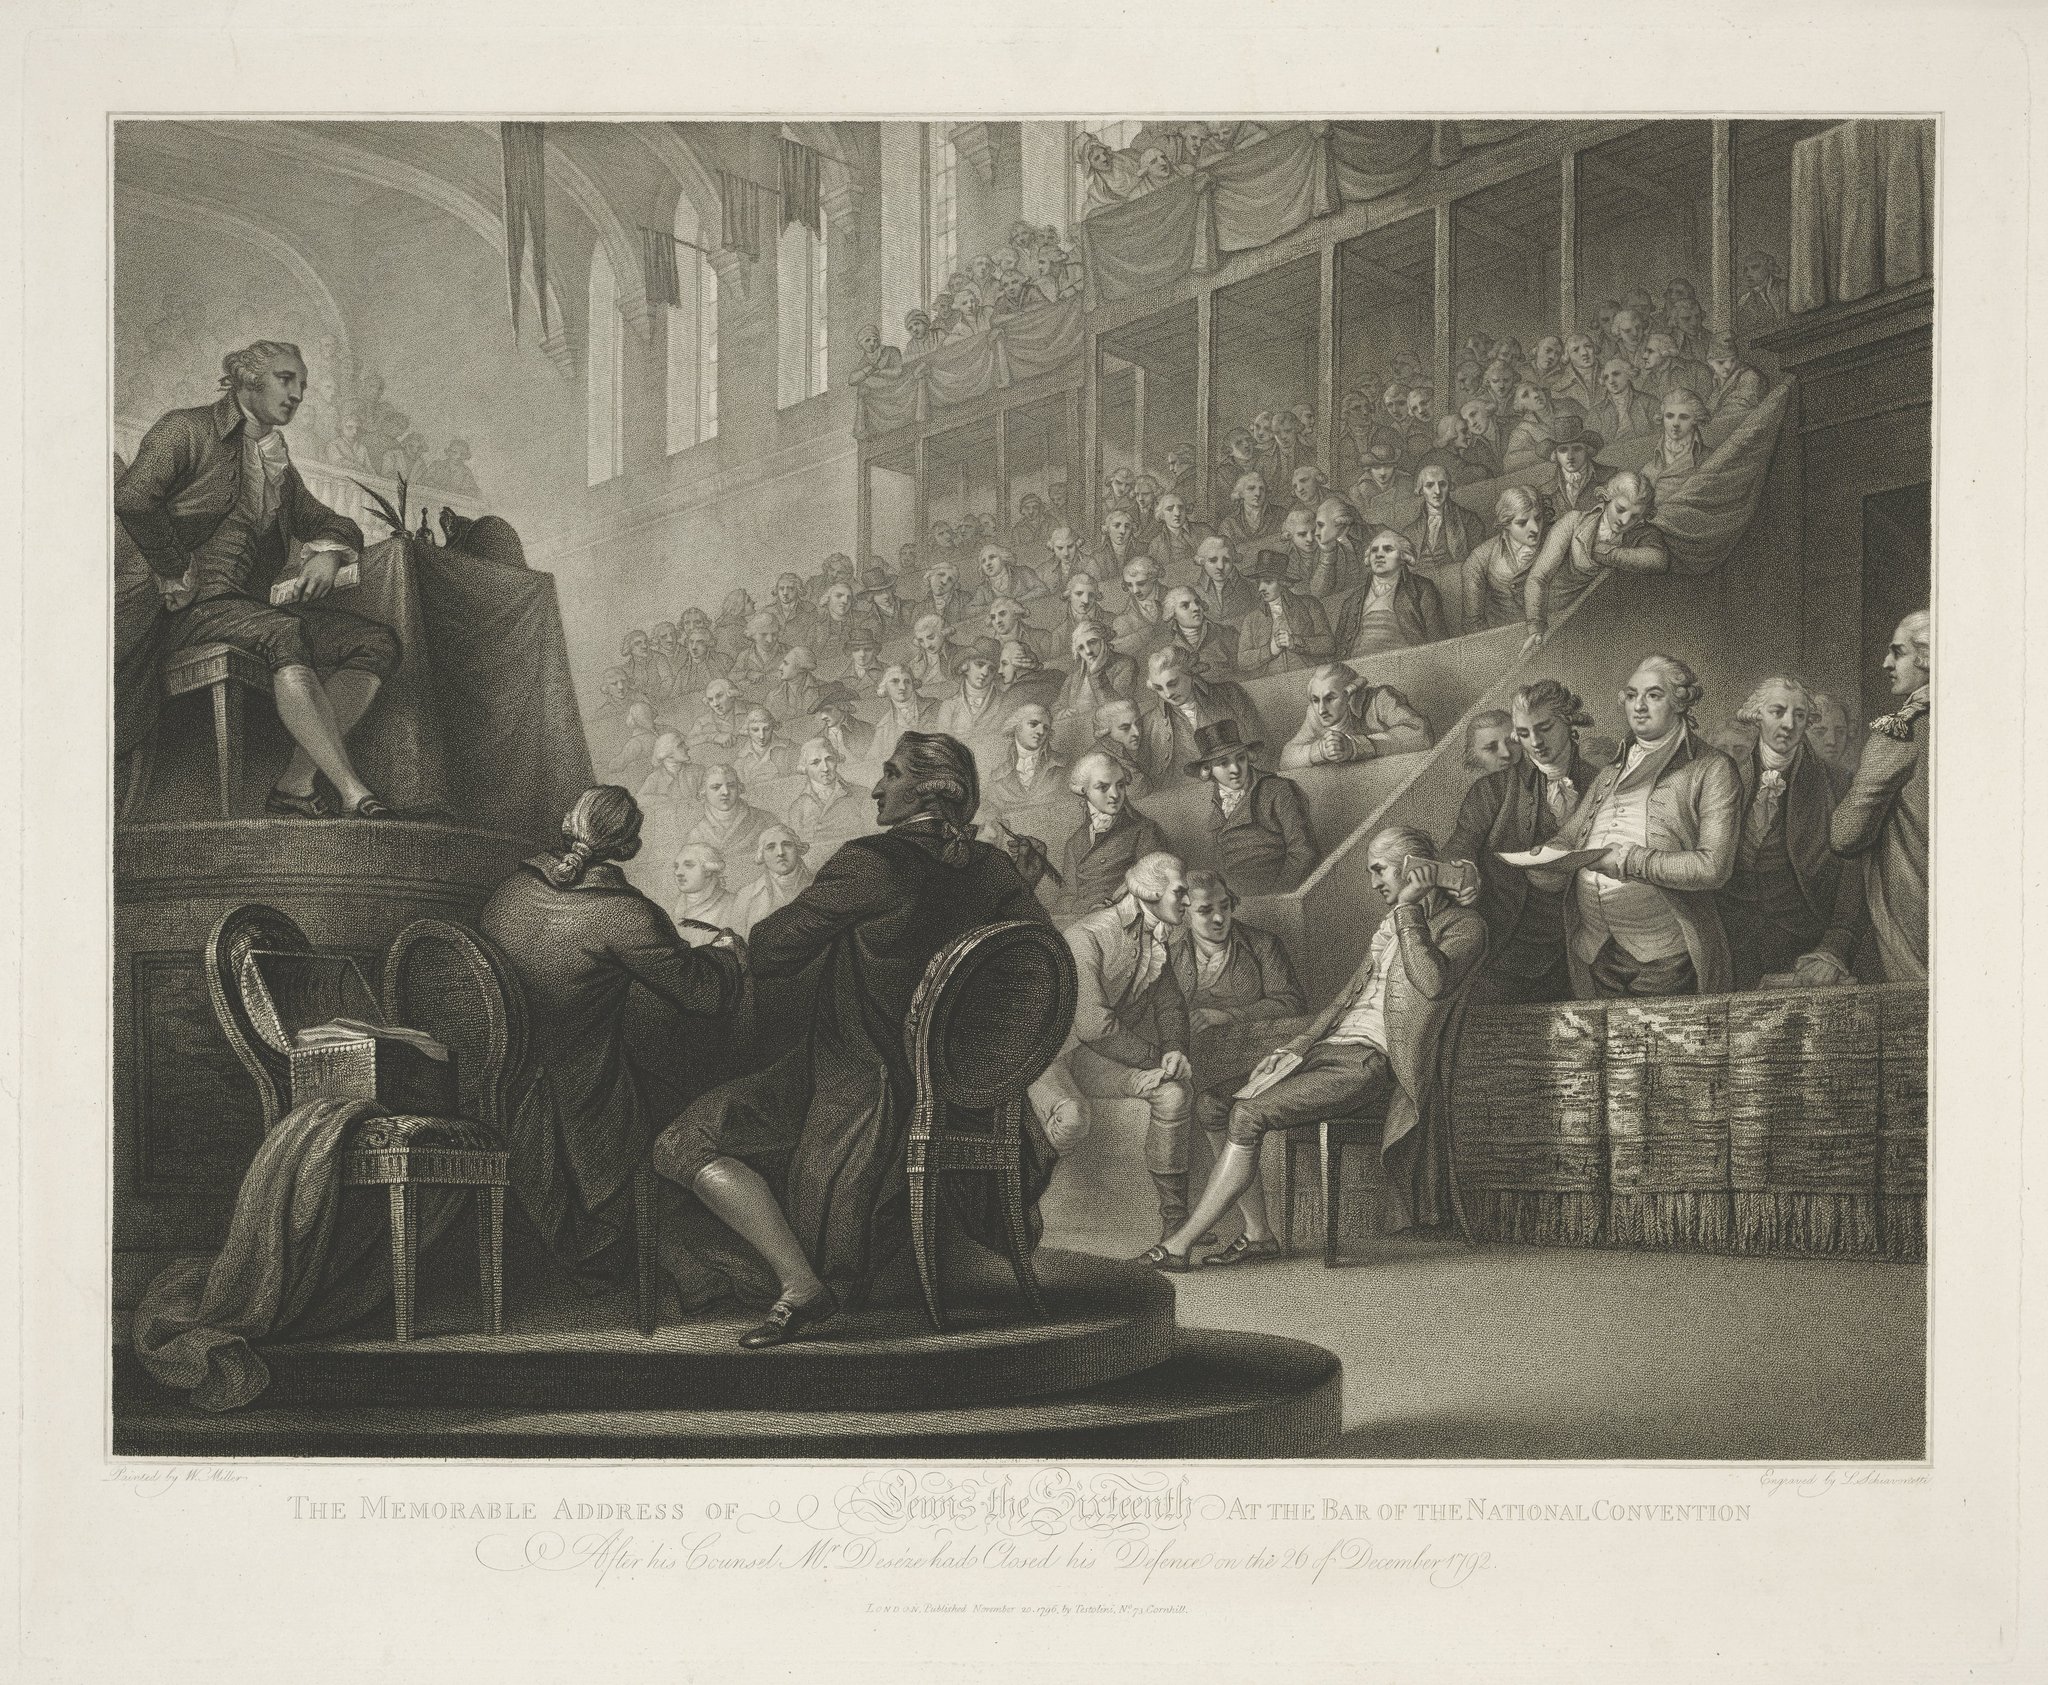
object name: print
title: The memorable address of Lewis the Sixteenth at the bar of the National Convention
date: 1796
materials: paper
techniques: stippled etching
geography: london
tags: paris, lodewijk xvi (koning van frankrijk), historical persons, court session (court of justice)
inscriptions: collector's mark: Lugt 12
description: Lodewijk XVI houdt een toespraak voor de Nationale Conventie. Tekst in het Engels in de ondermarge.